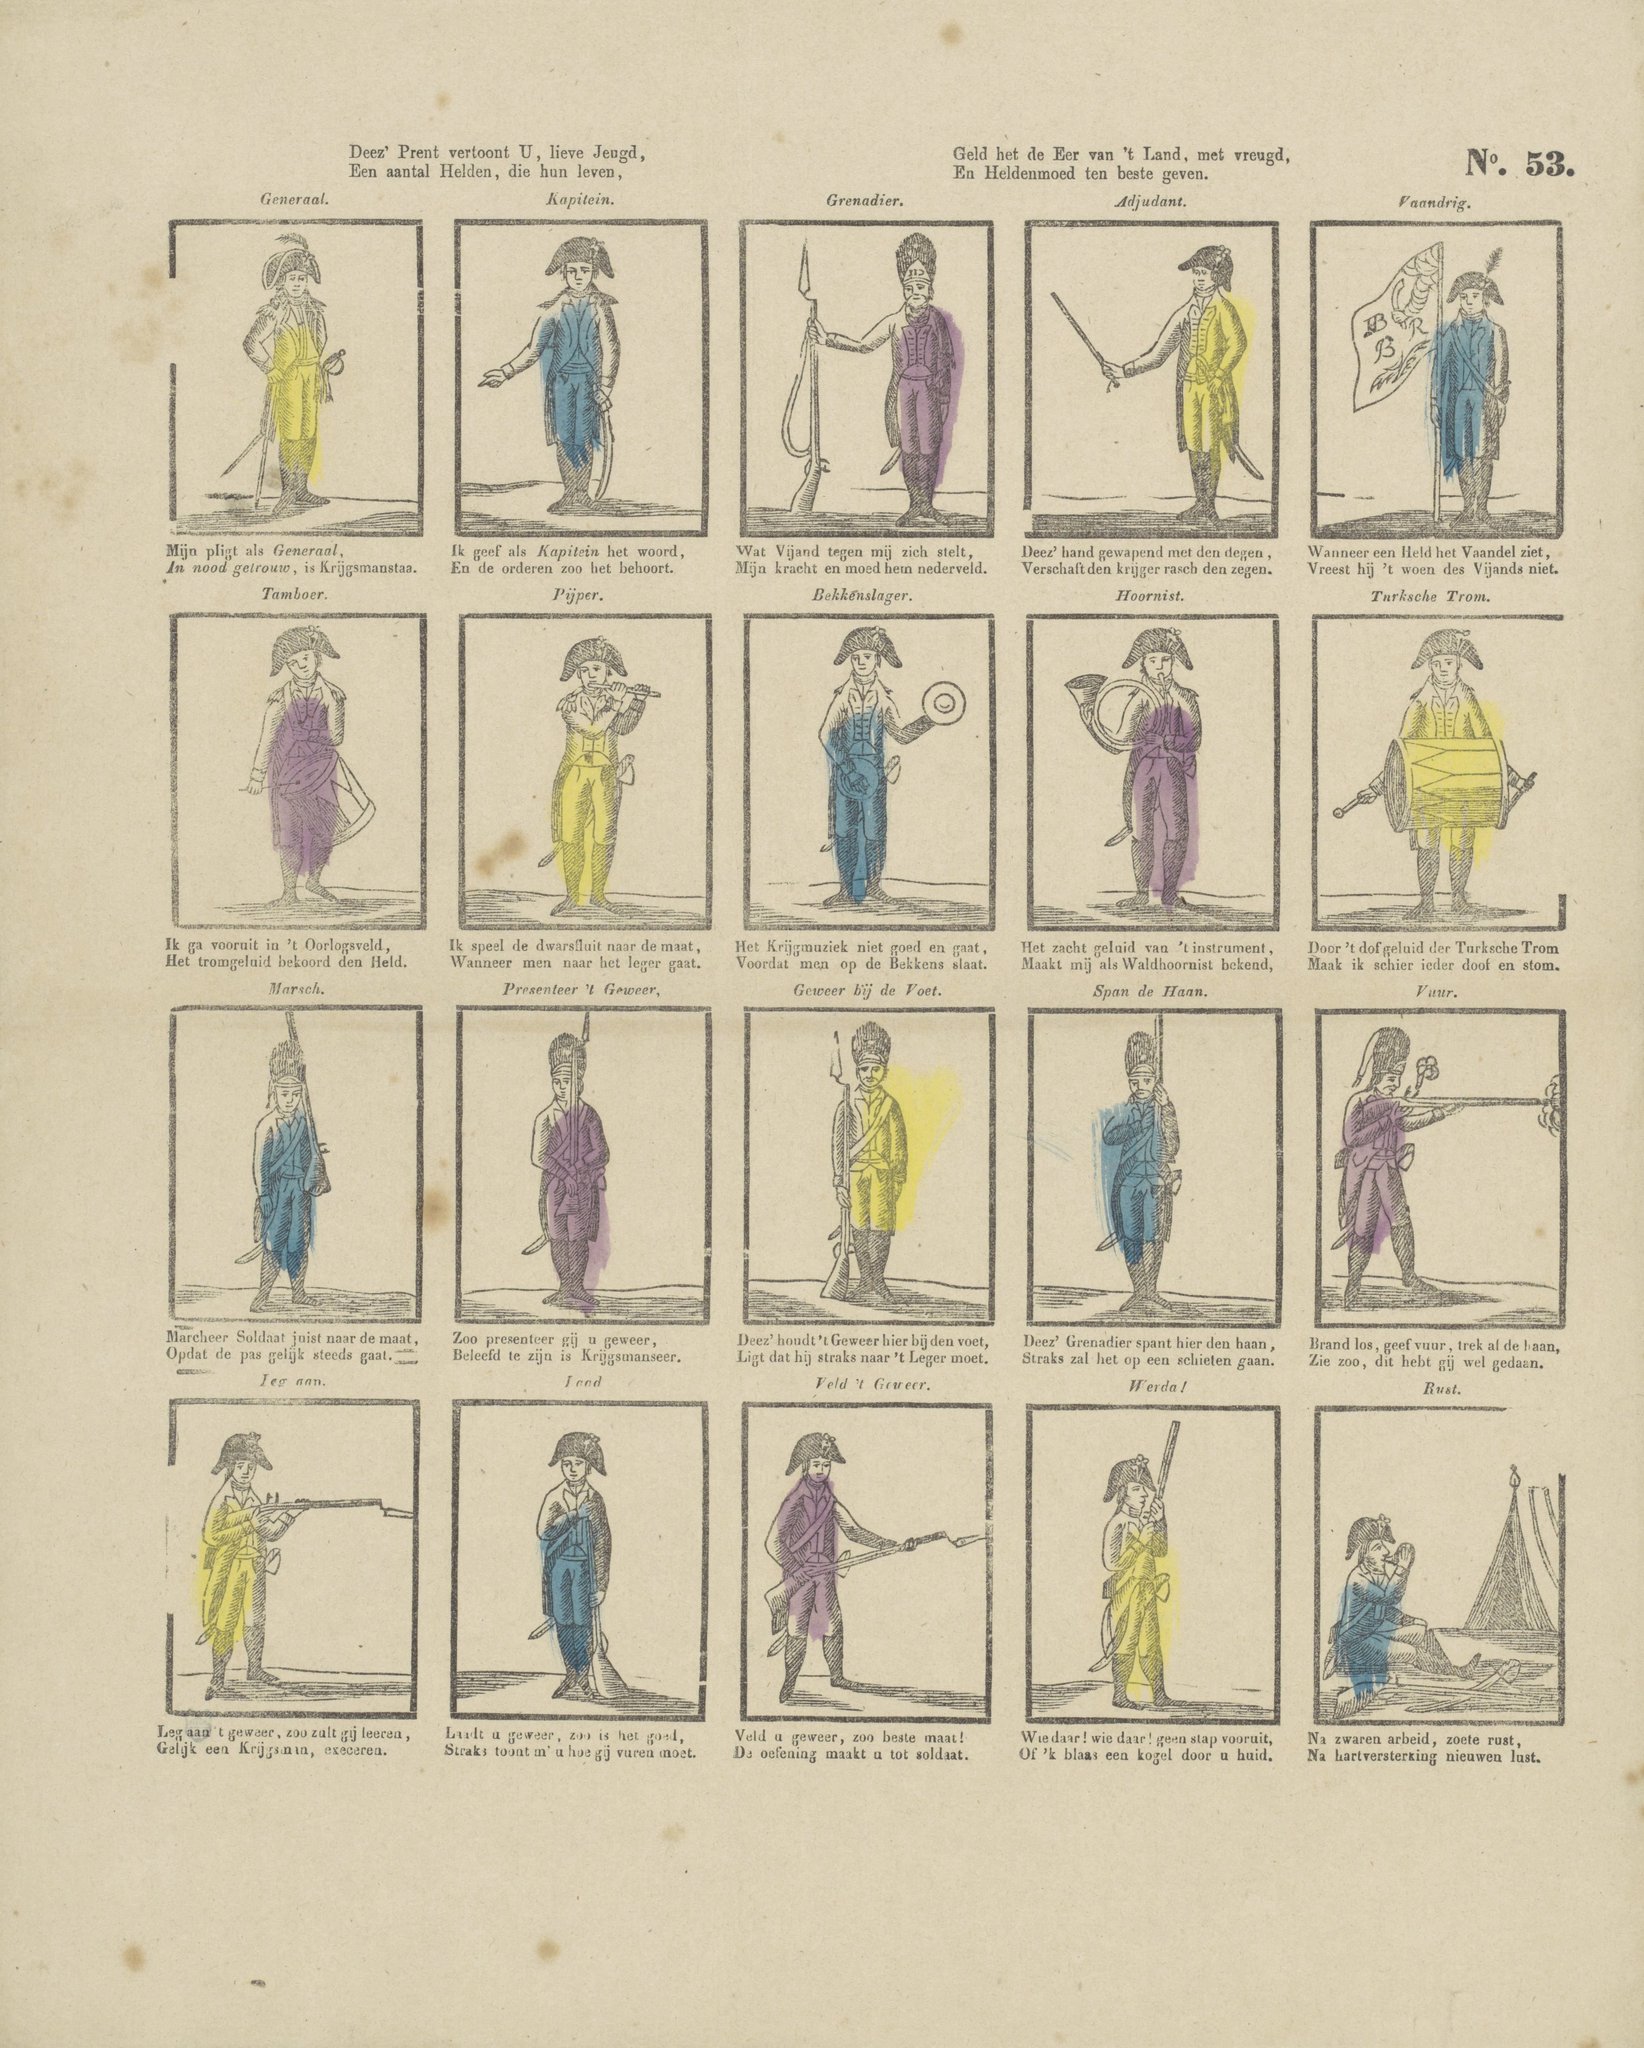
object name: print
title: Deez' prent vertoond u, lieve jeugd. / Een aantal helden, die hun leven. / Geld het de eer van 't land, met vreugd, / En heldenmoed ten beste geven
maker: Anonymous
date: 1850-1870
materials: paper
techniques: colour, letterpress printing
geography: netherlands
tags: military band, the soldier; the soldier's life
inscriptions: collector's mark: Lugt 2760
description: Blad met 20 voorstellingen van militairen. Onder elke afbeelding een tweeregelig vers. Genummerd rechtsboven: No. 53.